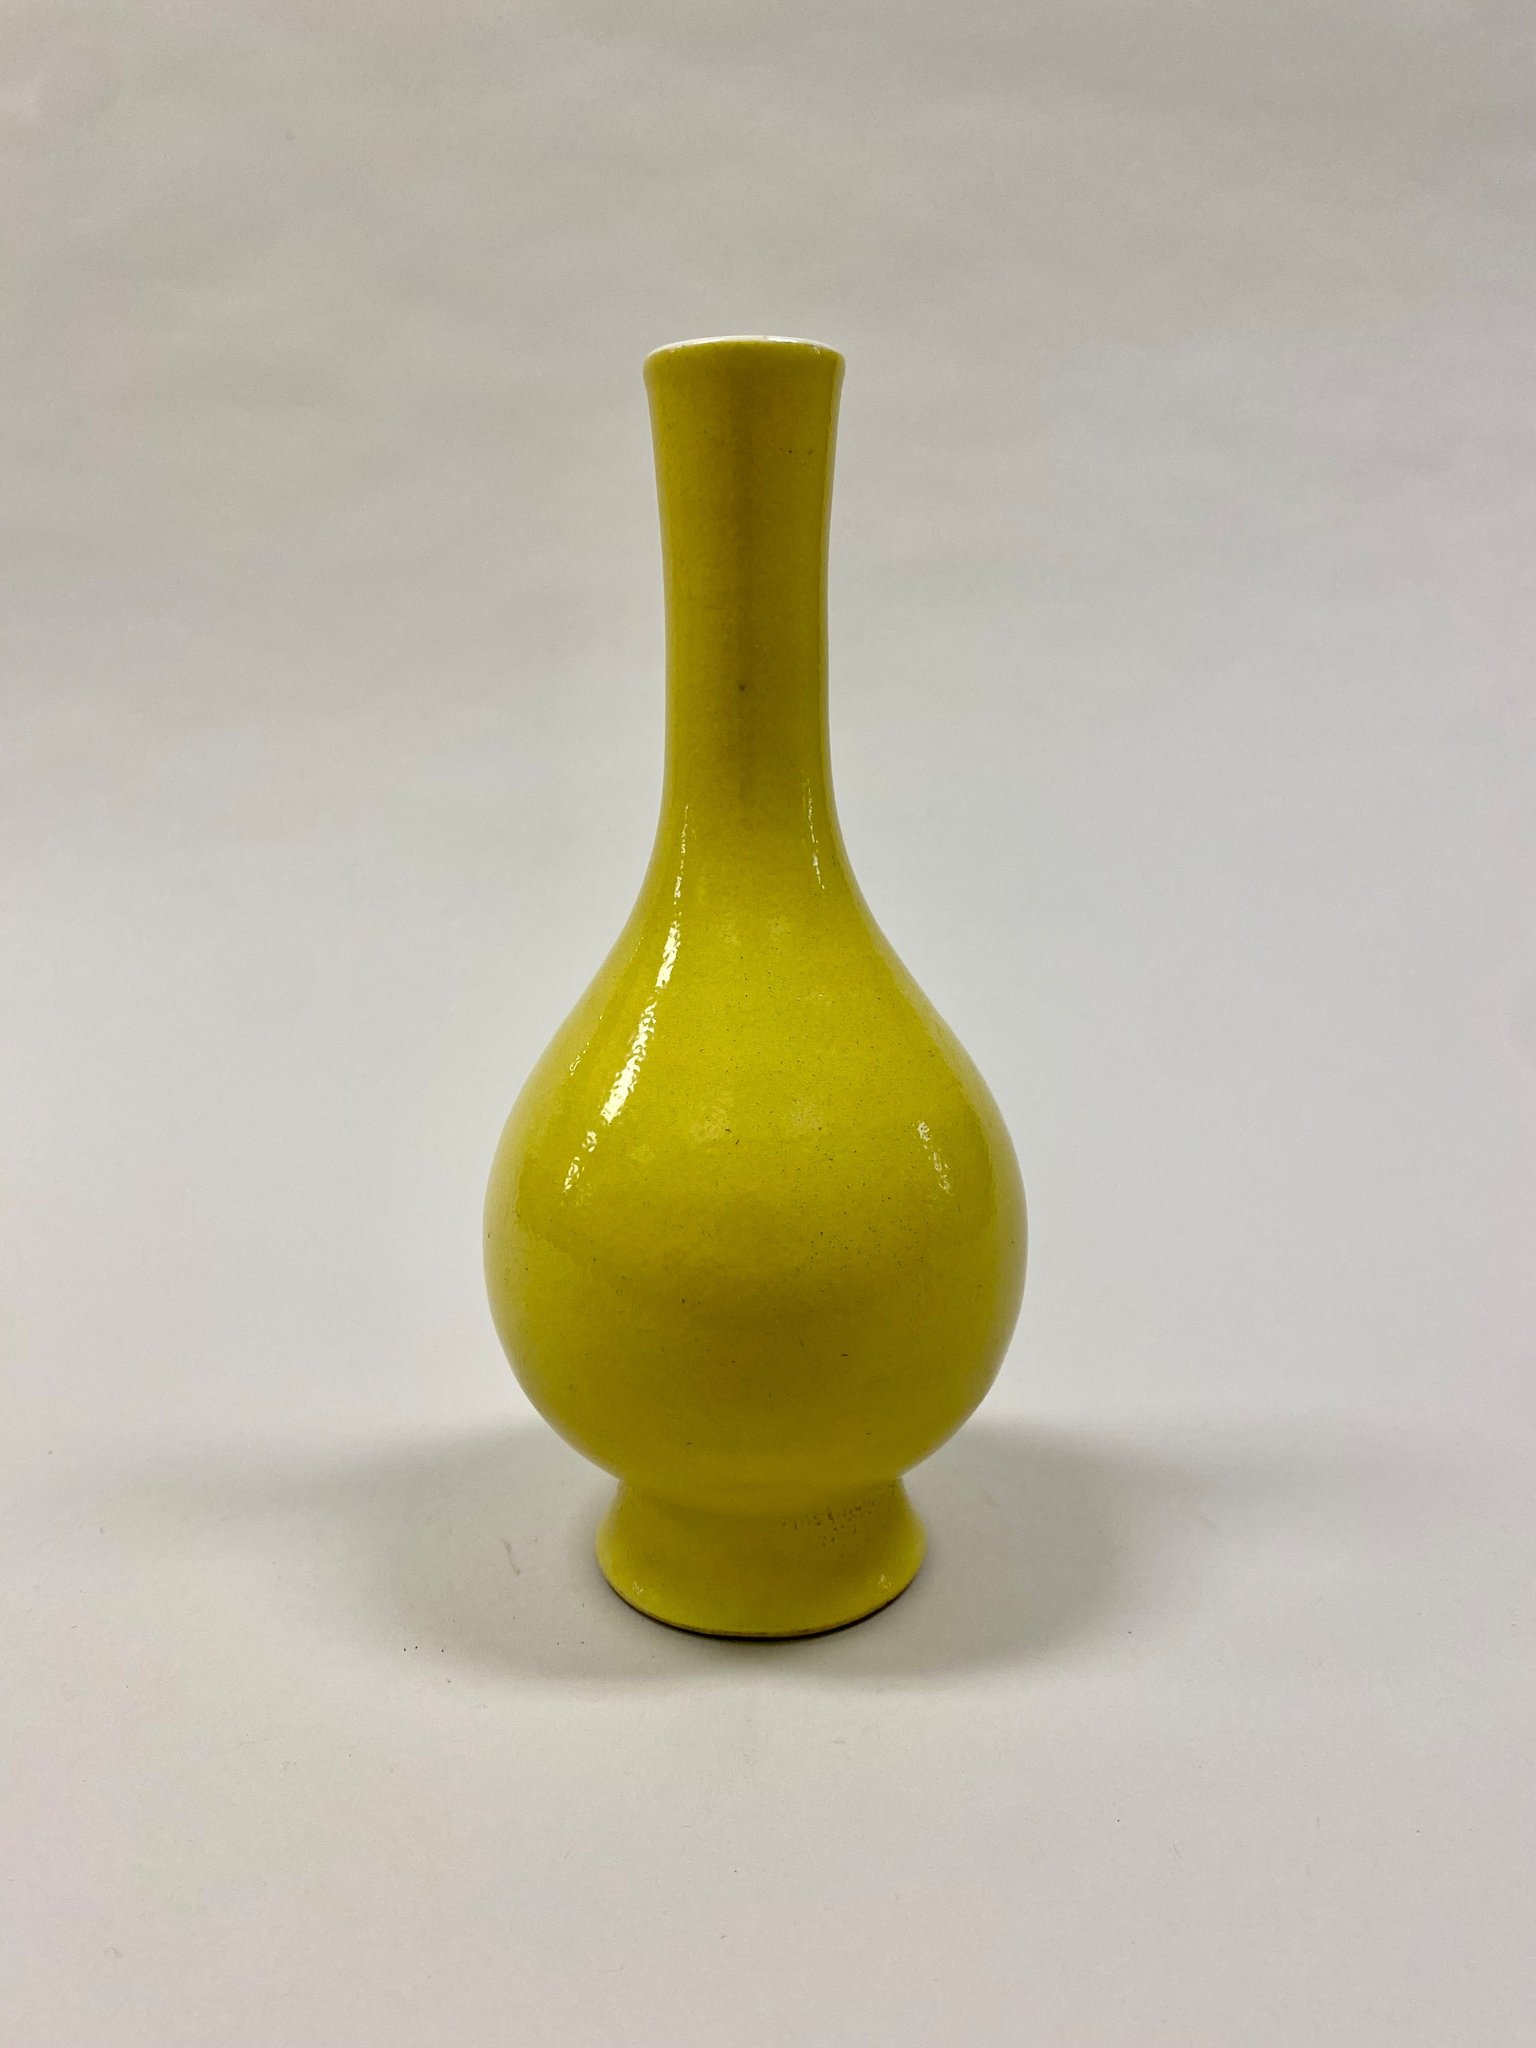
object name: bottle vase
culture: chinese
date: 1701-1800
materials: glaze, porcelain